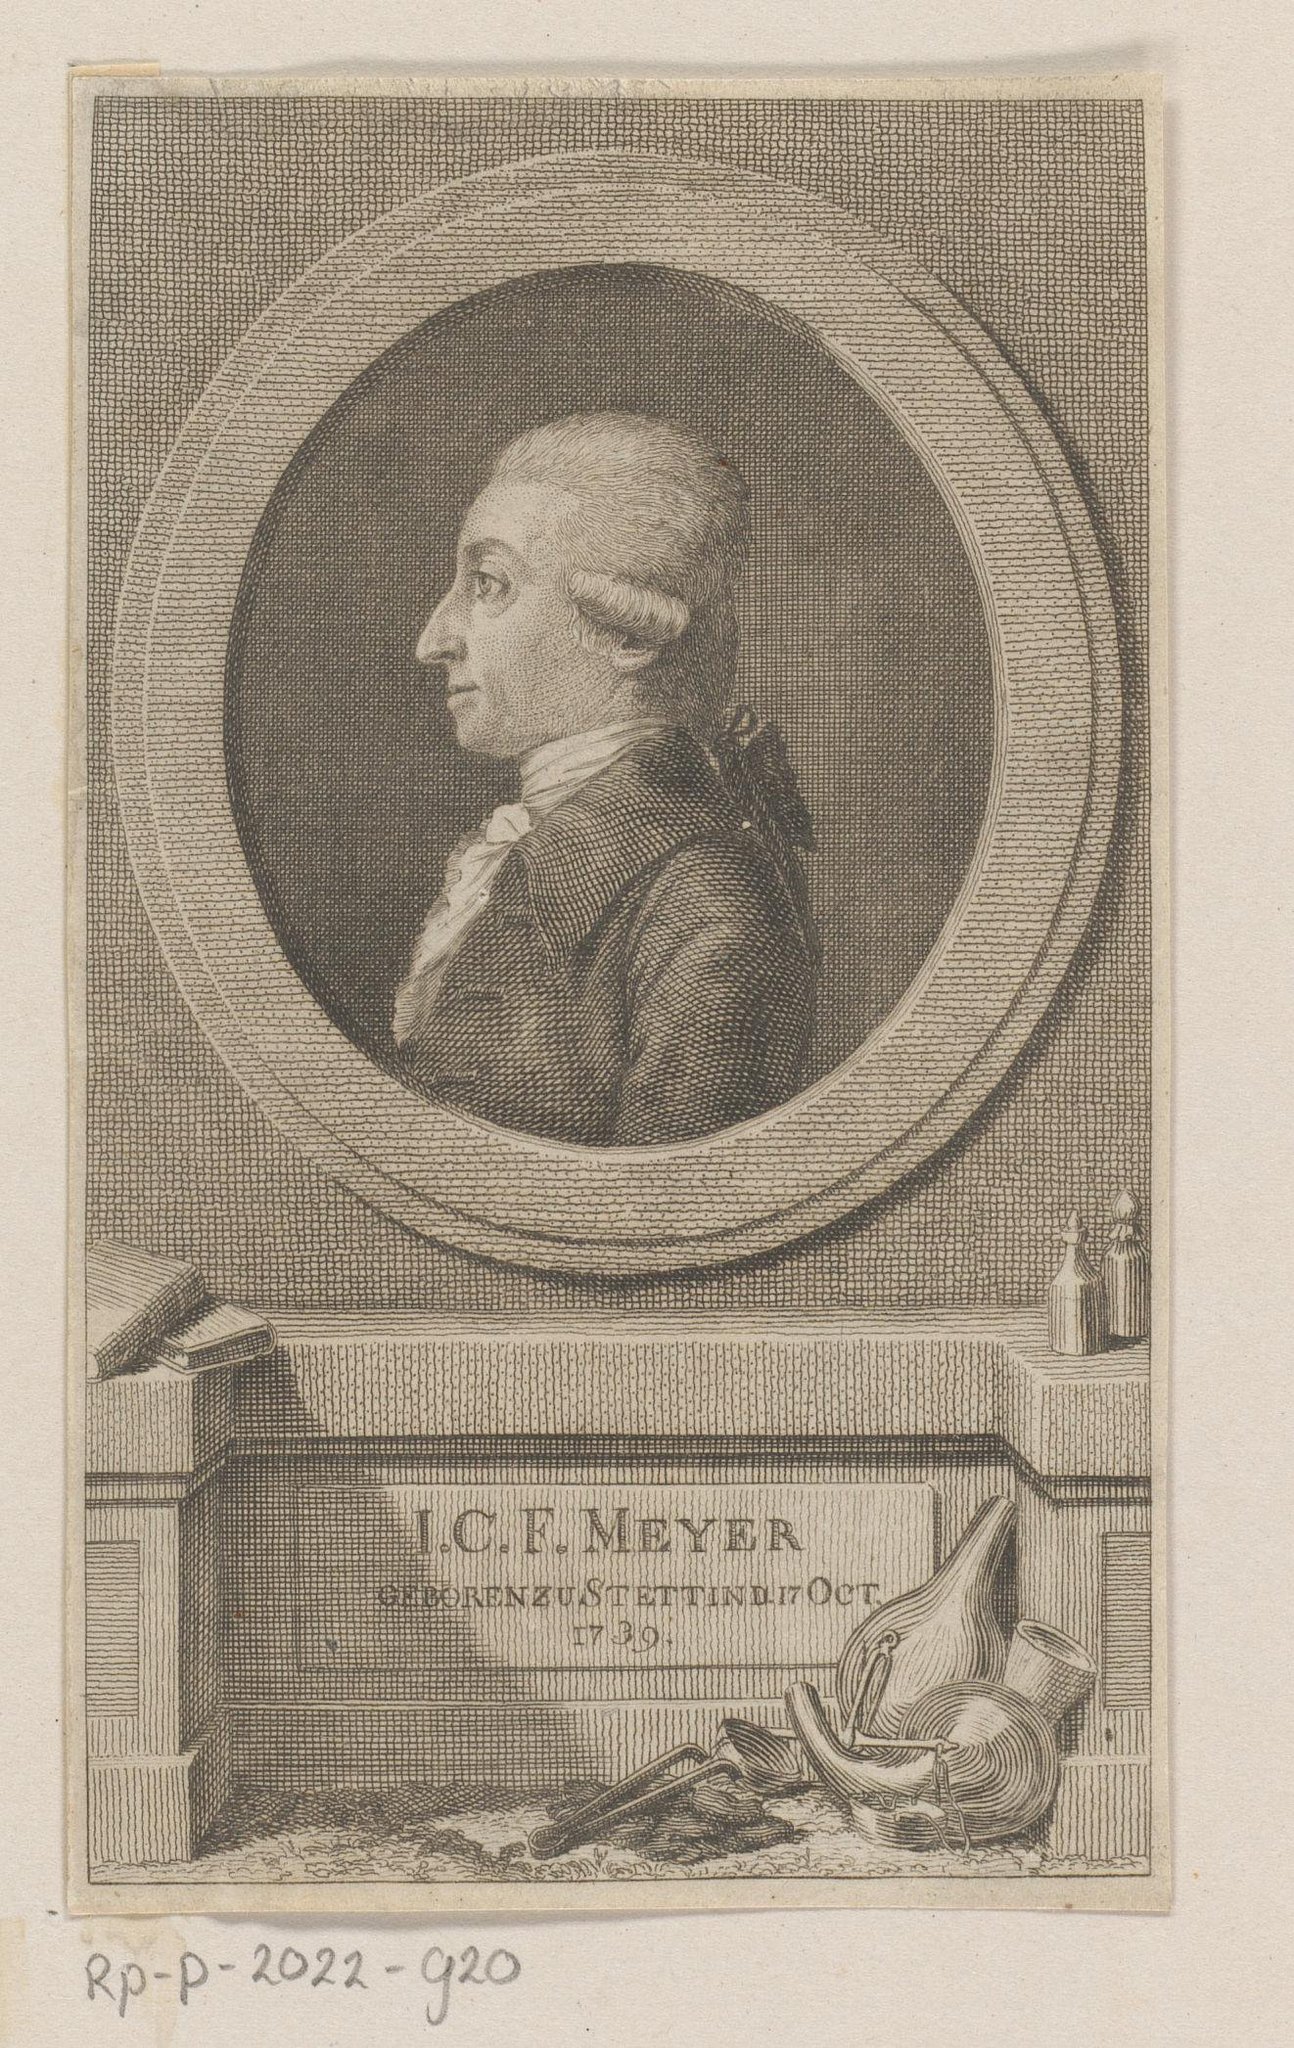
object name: print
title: I.C.F. Meyer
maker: eberhard siegfried henne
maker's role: print maker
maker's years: 1759-1828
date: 1769-1811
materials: paper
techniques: etching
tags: berlin, historical persons, tools and implements of pharmacist